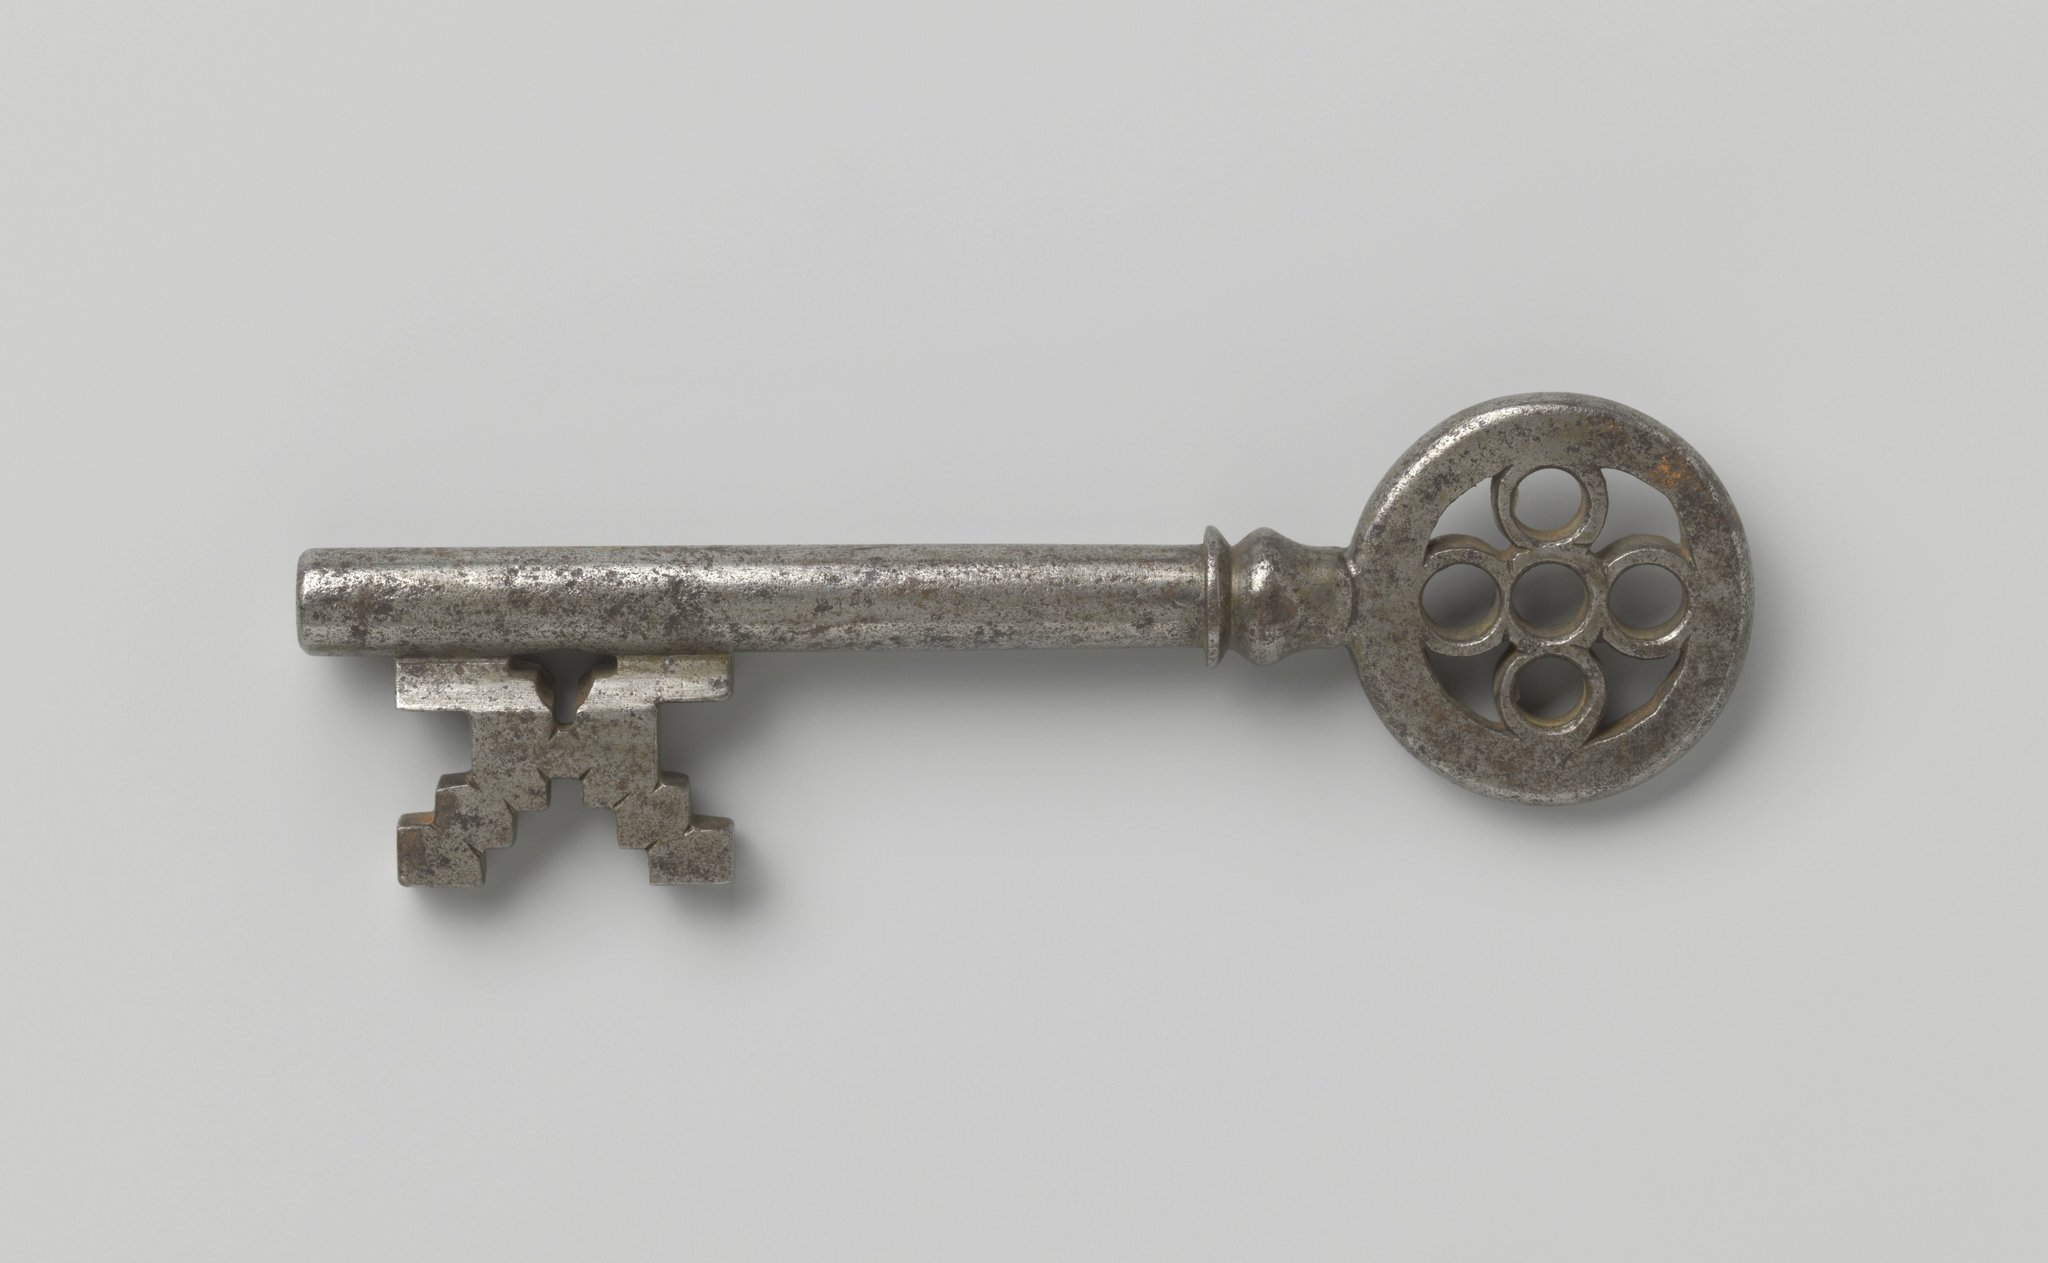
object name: key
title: Sleutel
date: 1800-1900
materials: iron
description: Sleutel met cirkelvormig oog waarin zich vijf kruisgewijs geplaatste ringetjes bevinden..